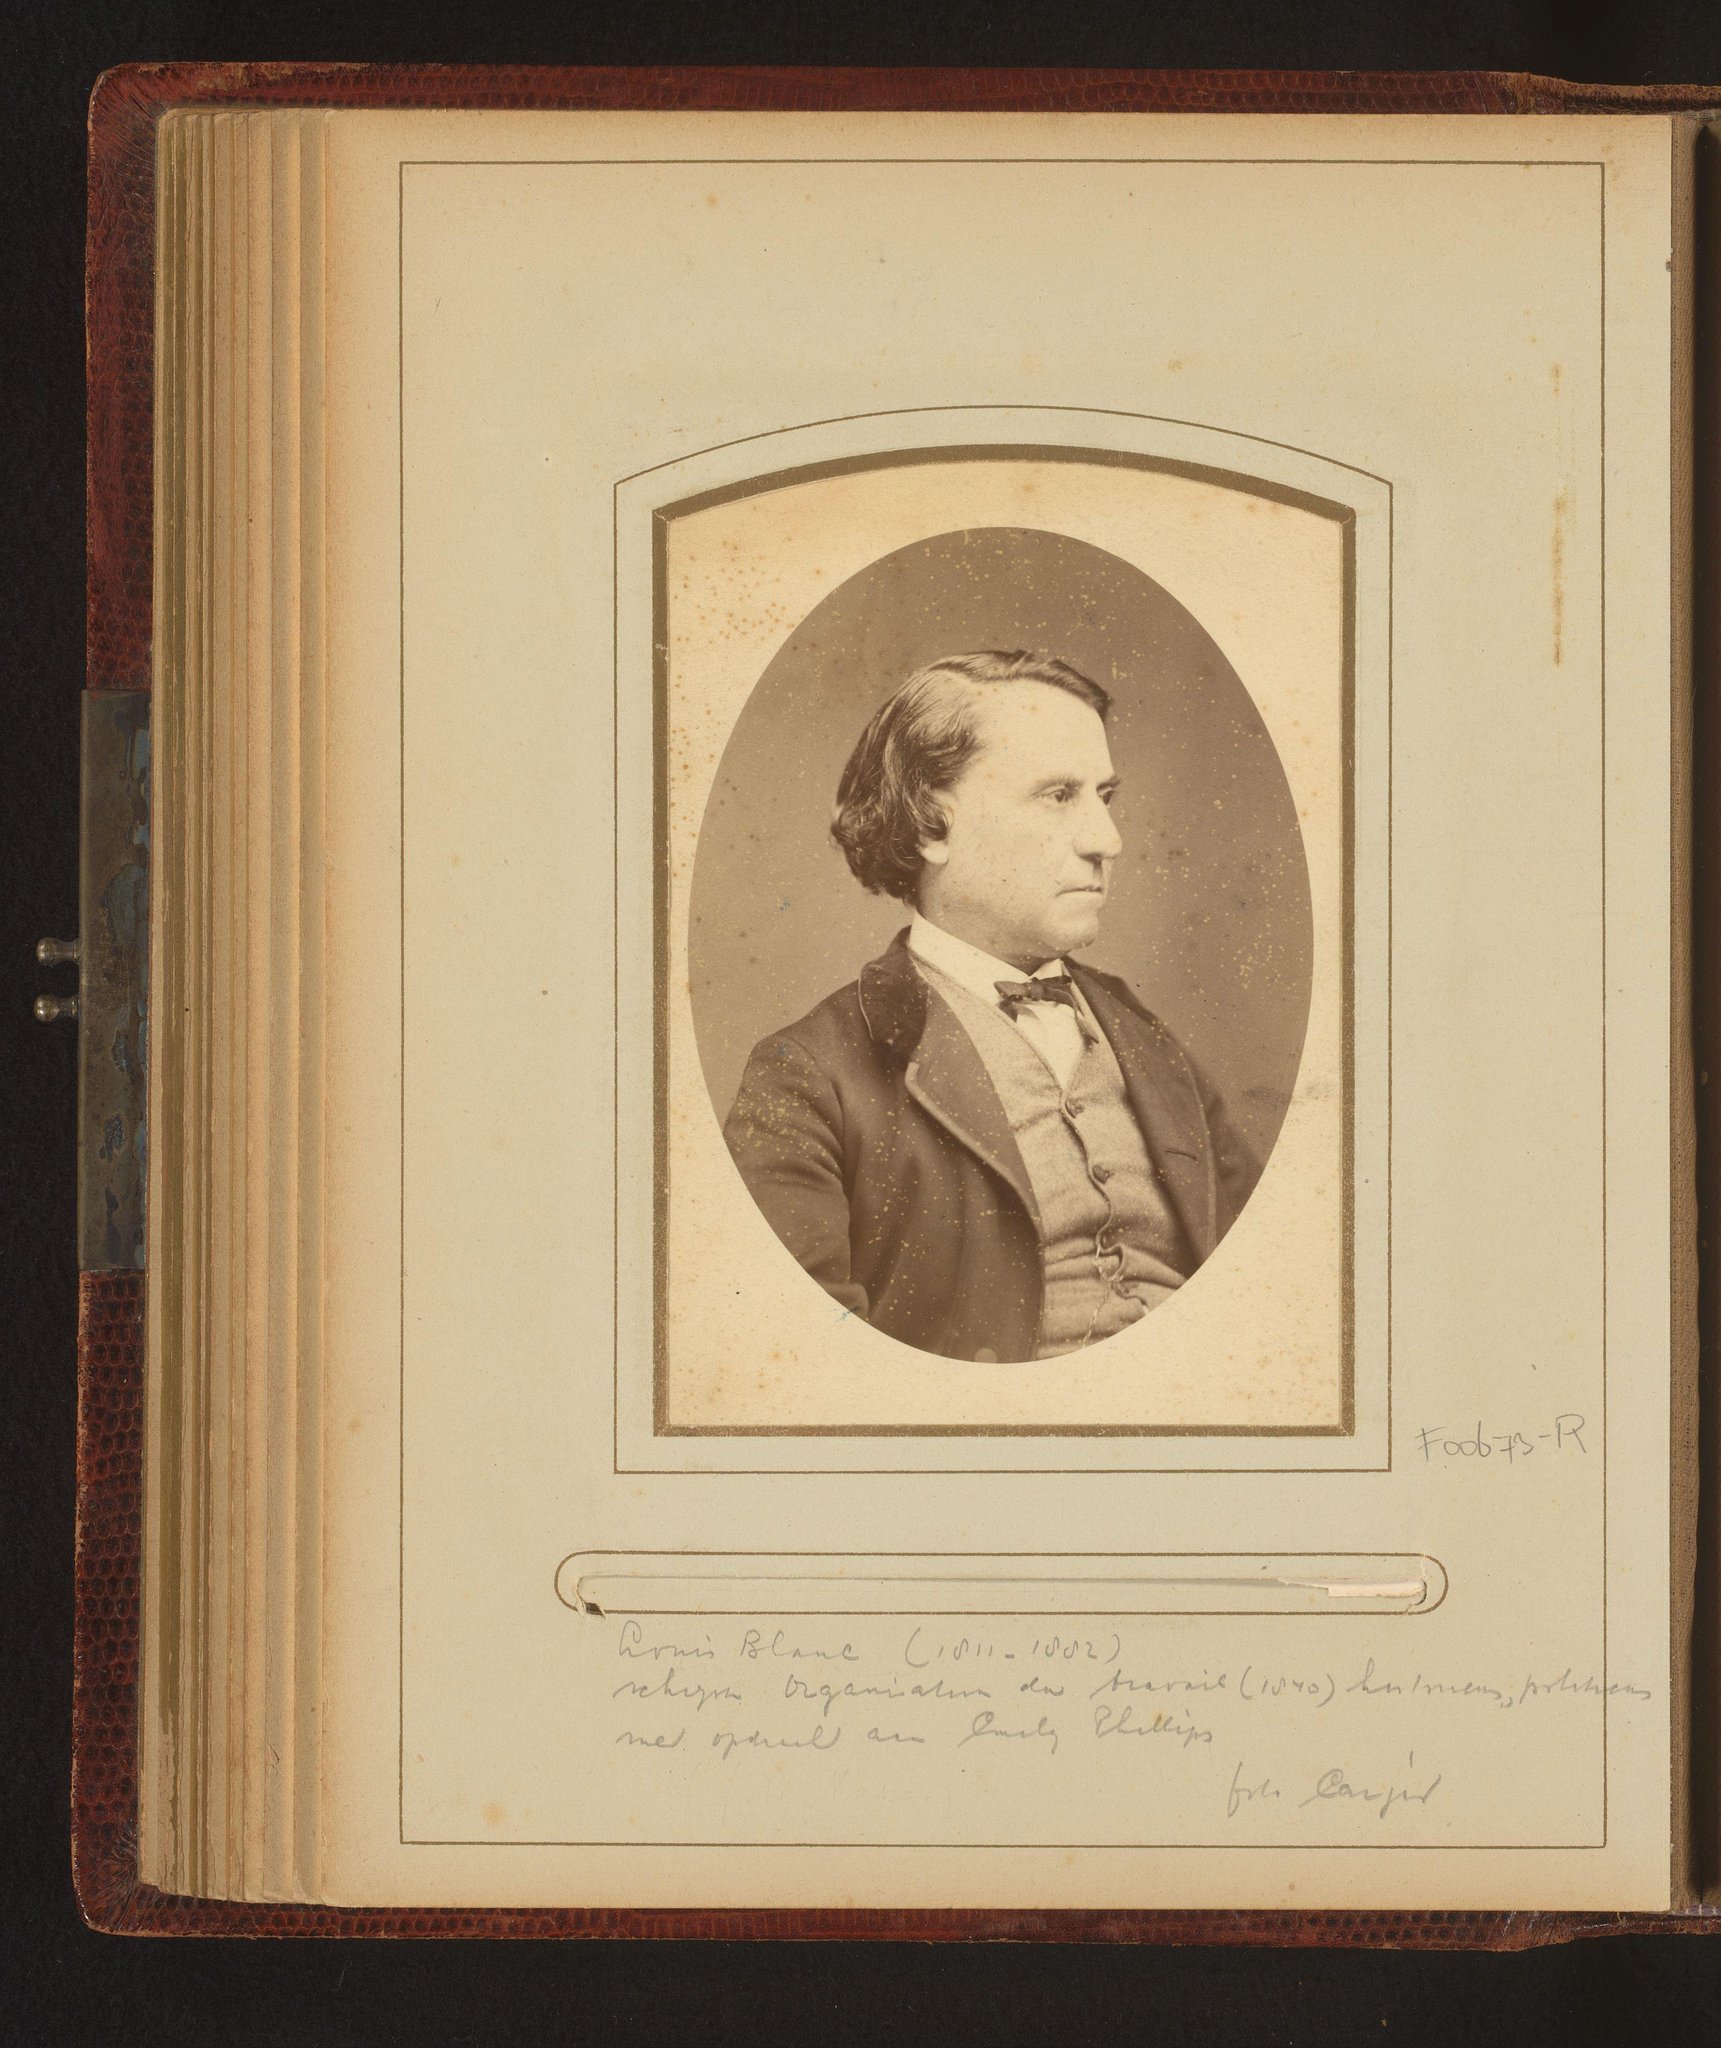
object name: album leaf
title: Portret van Louis Blanc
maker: étienne carjat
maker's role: draughtsman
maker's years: 1828-1906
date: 1867-1875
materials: cardboard, photographic support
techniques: albumen print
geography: paris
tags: politician, historical persons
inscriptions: annotation: ‘Louis Blanc (1811-1882) (...) met opdruk van Emily Philips/ foto Carjat’, annotation: ‘A Madame Emily Phillips/ Son ami dévoué/ Louis Blanc’